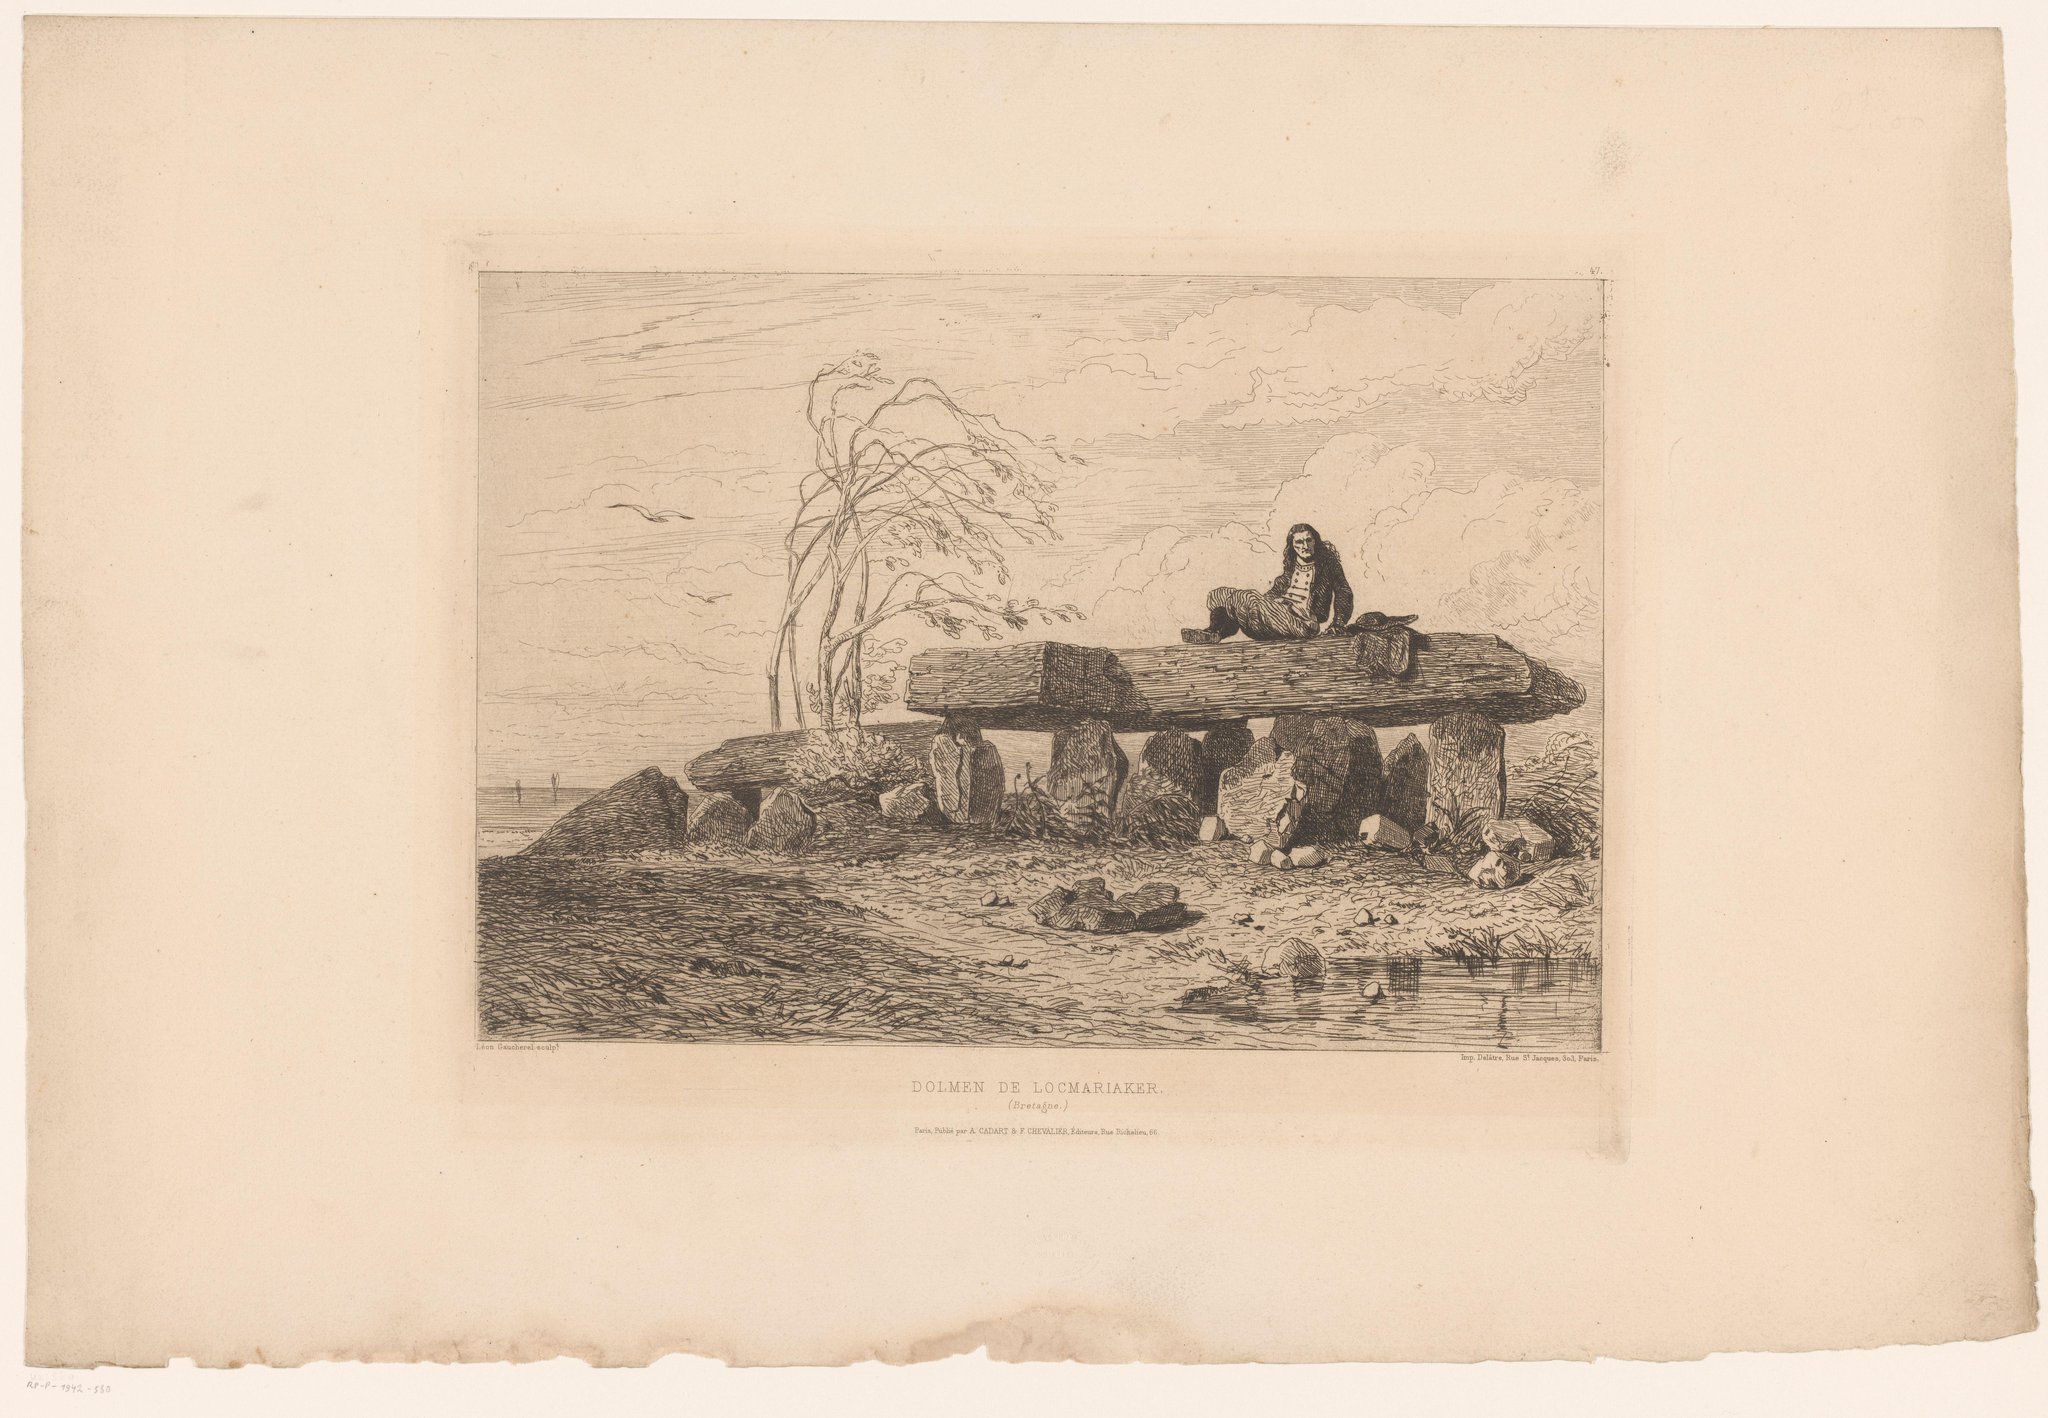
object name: print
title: Dolmen de Locmariaker.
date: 1832-1886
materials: paper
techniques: aquatint, drypoint, etching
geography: paris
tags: rock-formations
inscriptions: collector's mark: Lugt 3270, collector's mark: Lugt 2228